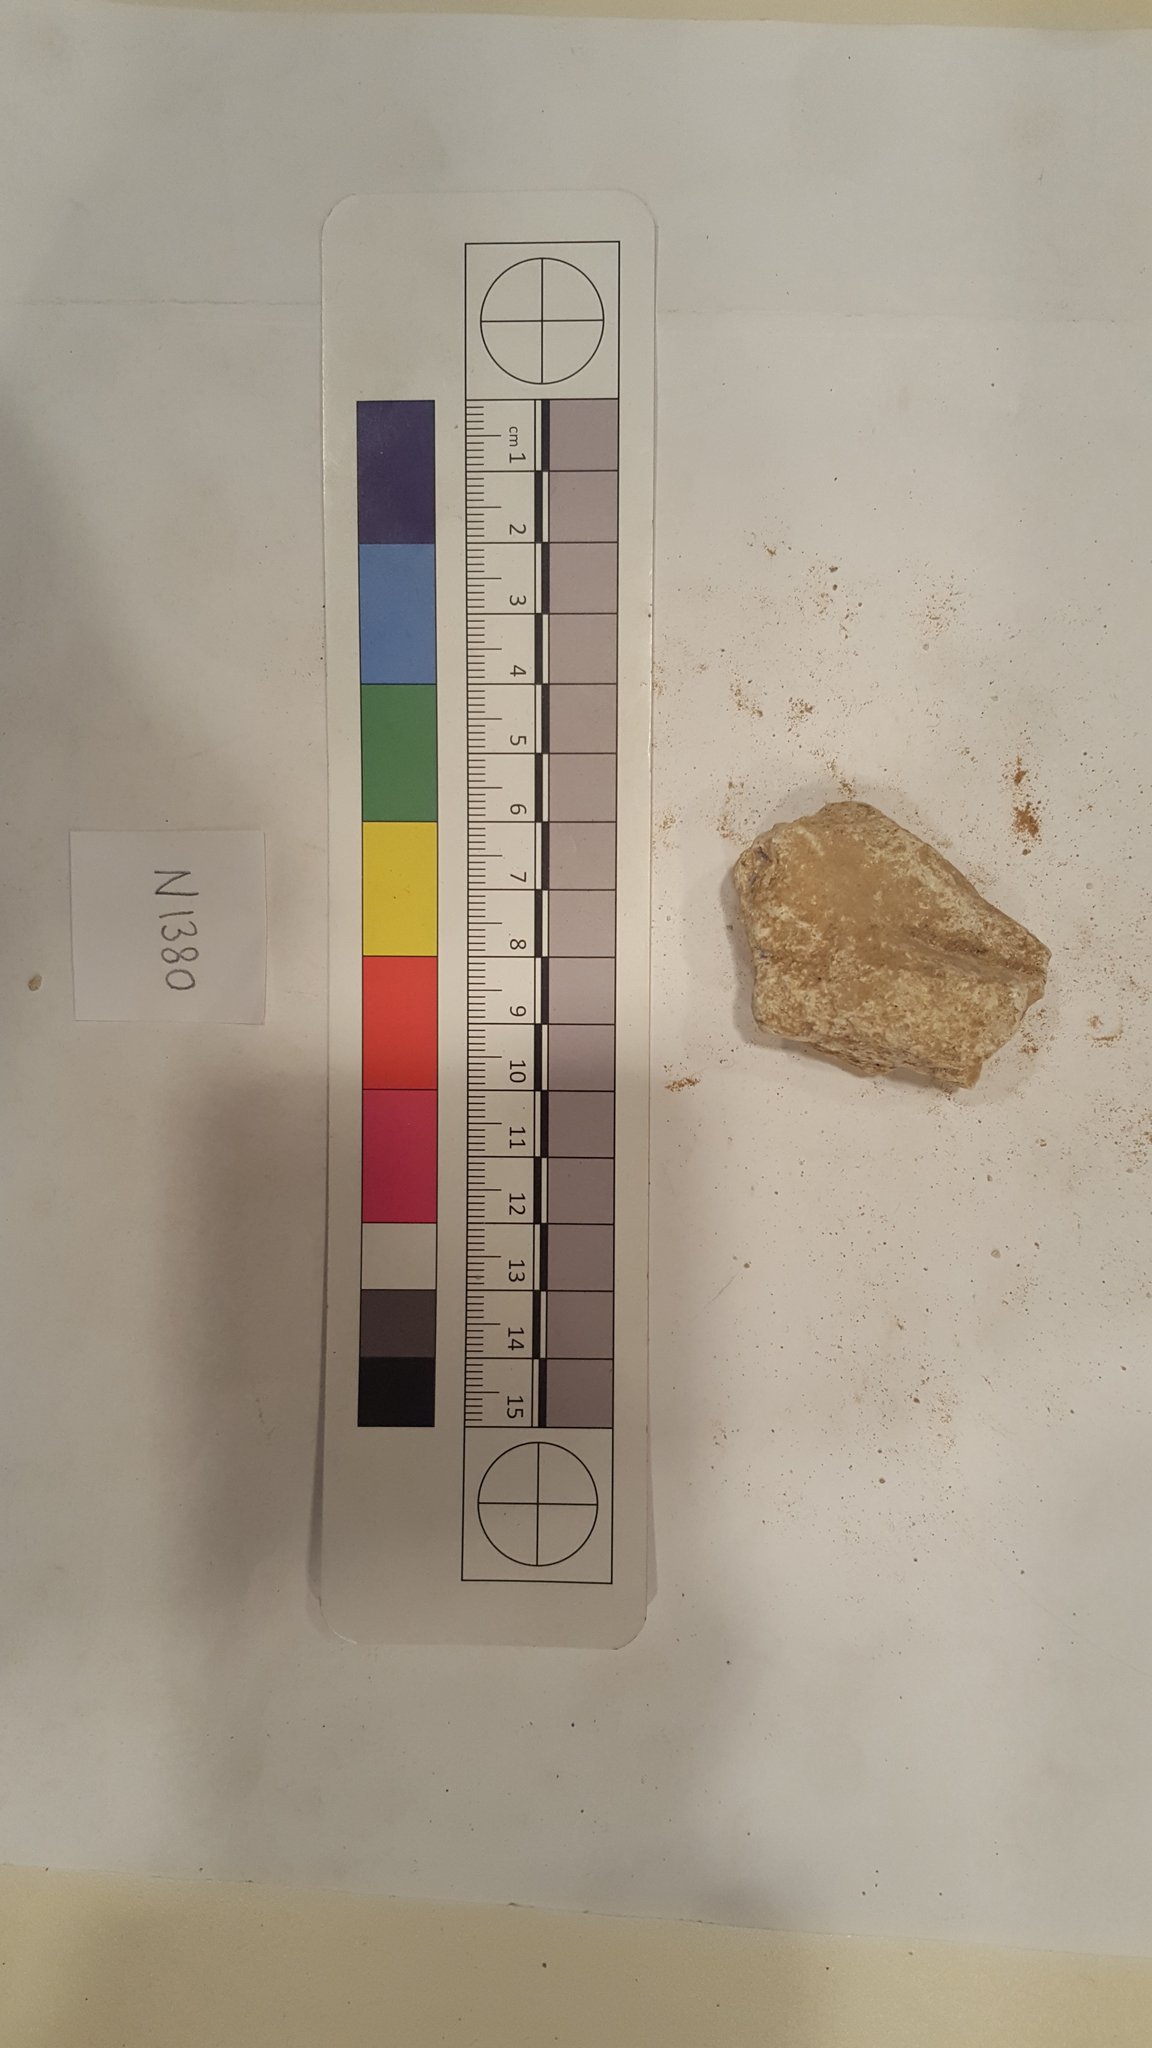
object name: fragment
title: Stucco Fragment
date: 701-1200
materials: plaster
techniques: carving, painting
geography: iran